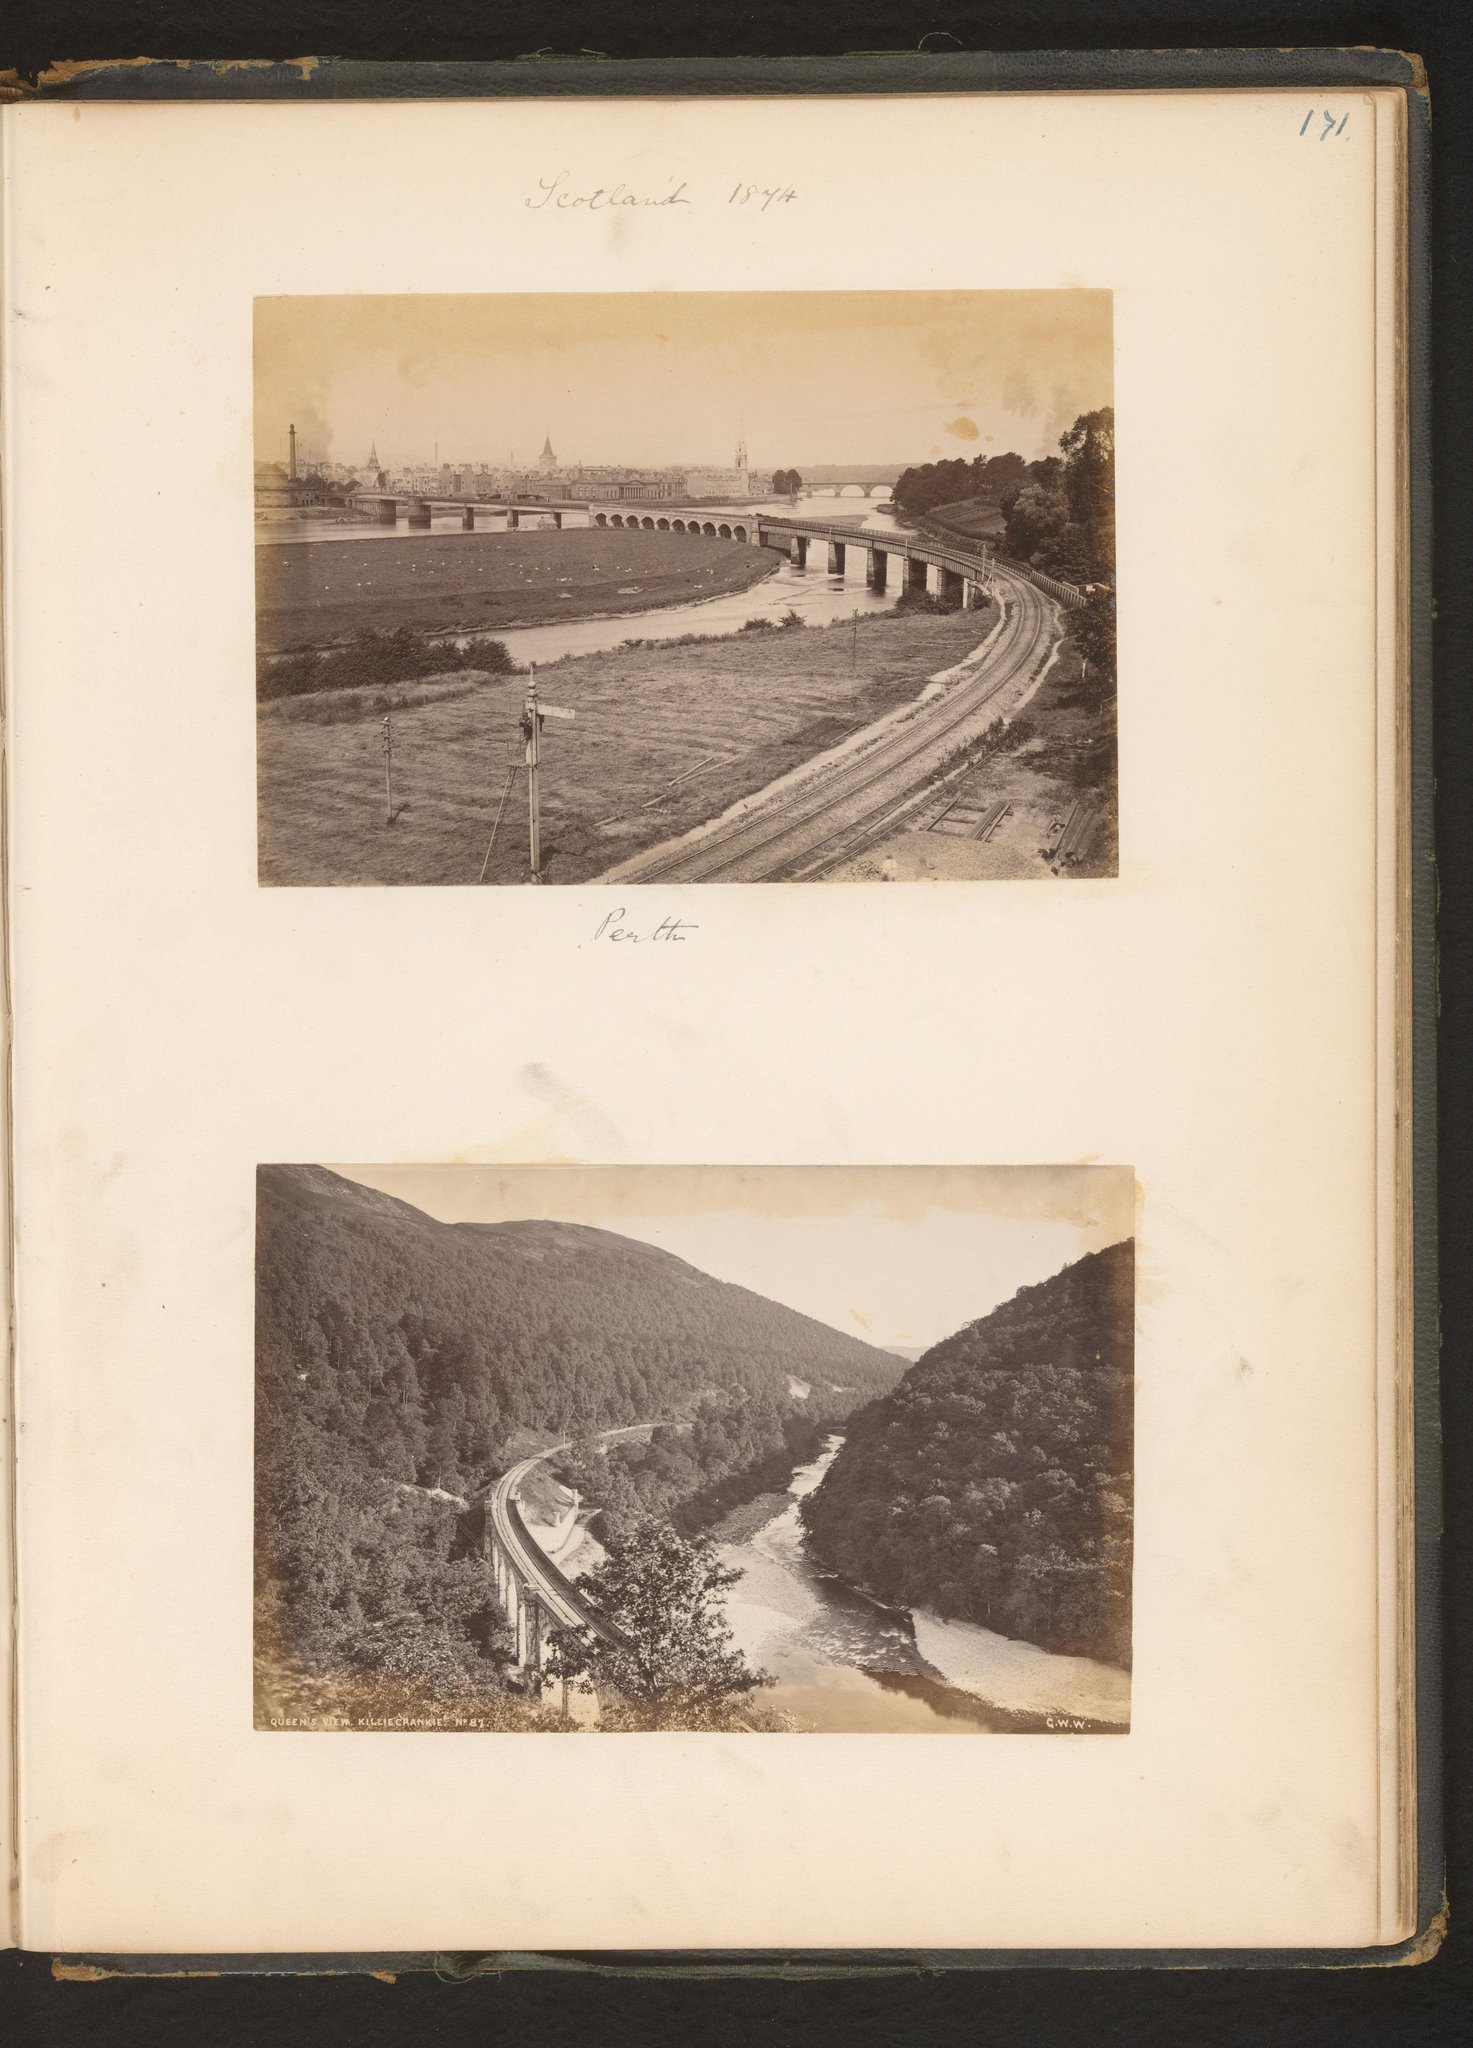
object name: album leaf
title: Gezicht op Perth en een uitzicht over Killiecrankie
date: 1874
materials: paper, photographic support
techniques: albumen print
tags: city-view in general; 'veduta', landscapes with waters, waterscapes, seascapes (in the temperate zone), railway, tramway; rack railway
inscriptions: inscription: ‘Queen's view. Killiecrankie No. 87 G.W.W.’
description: Deze pagina maakt deel uit van een album.